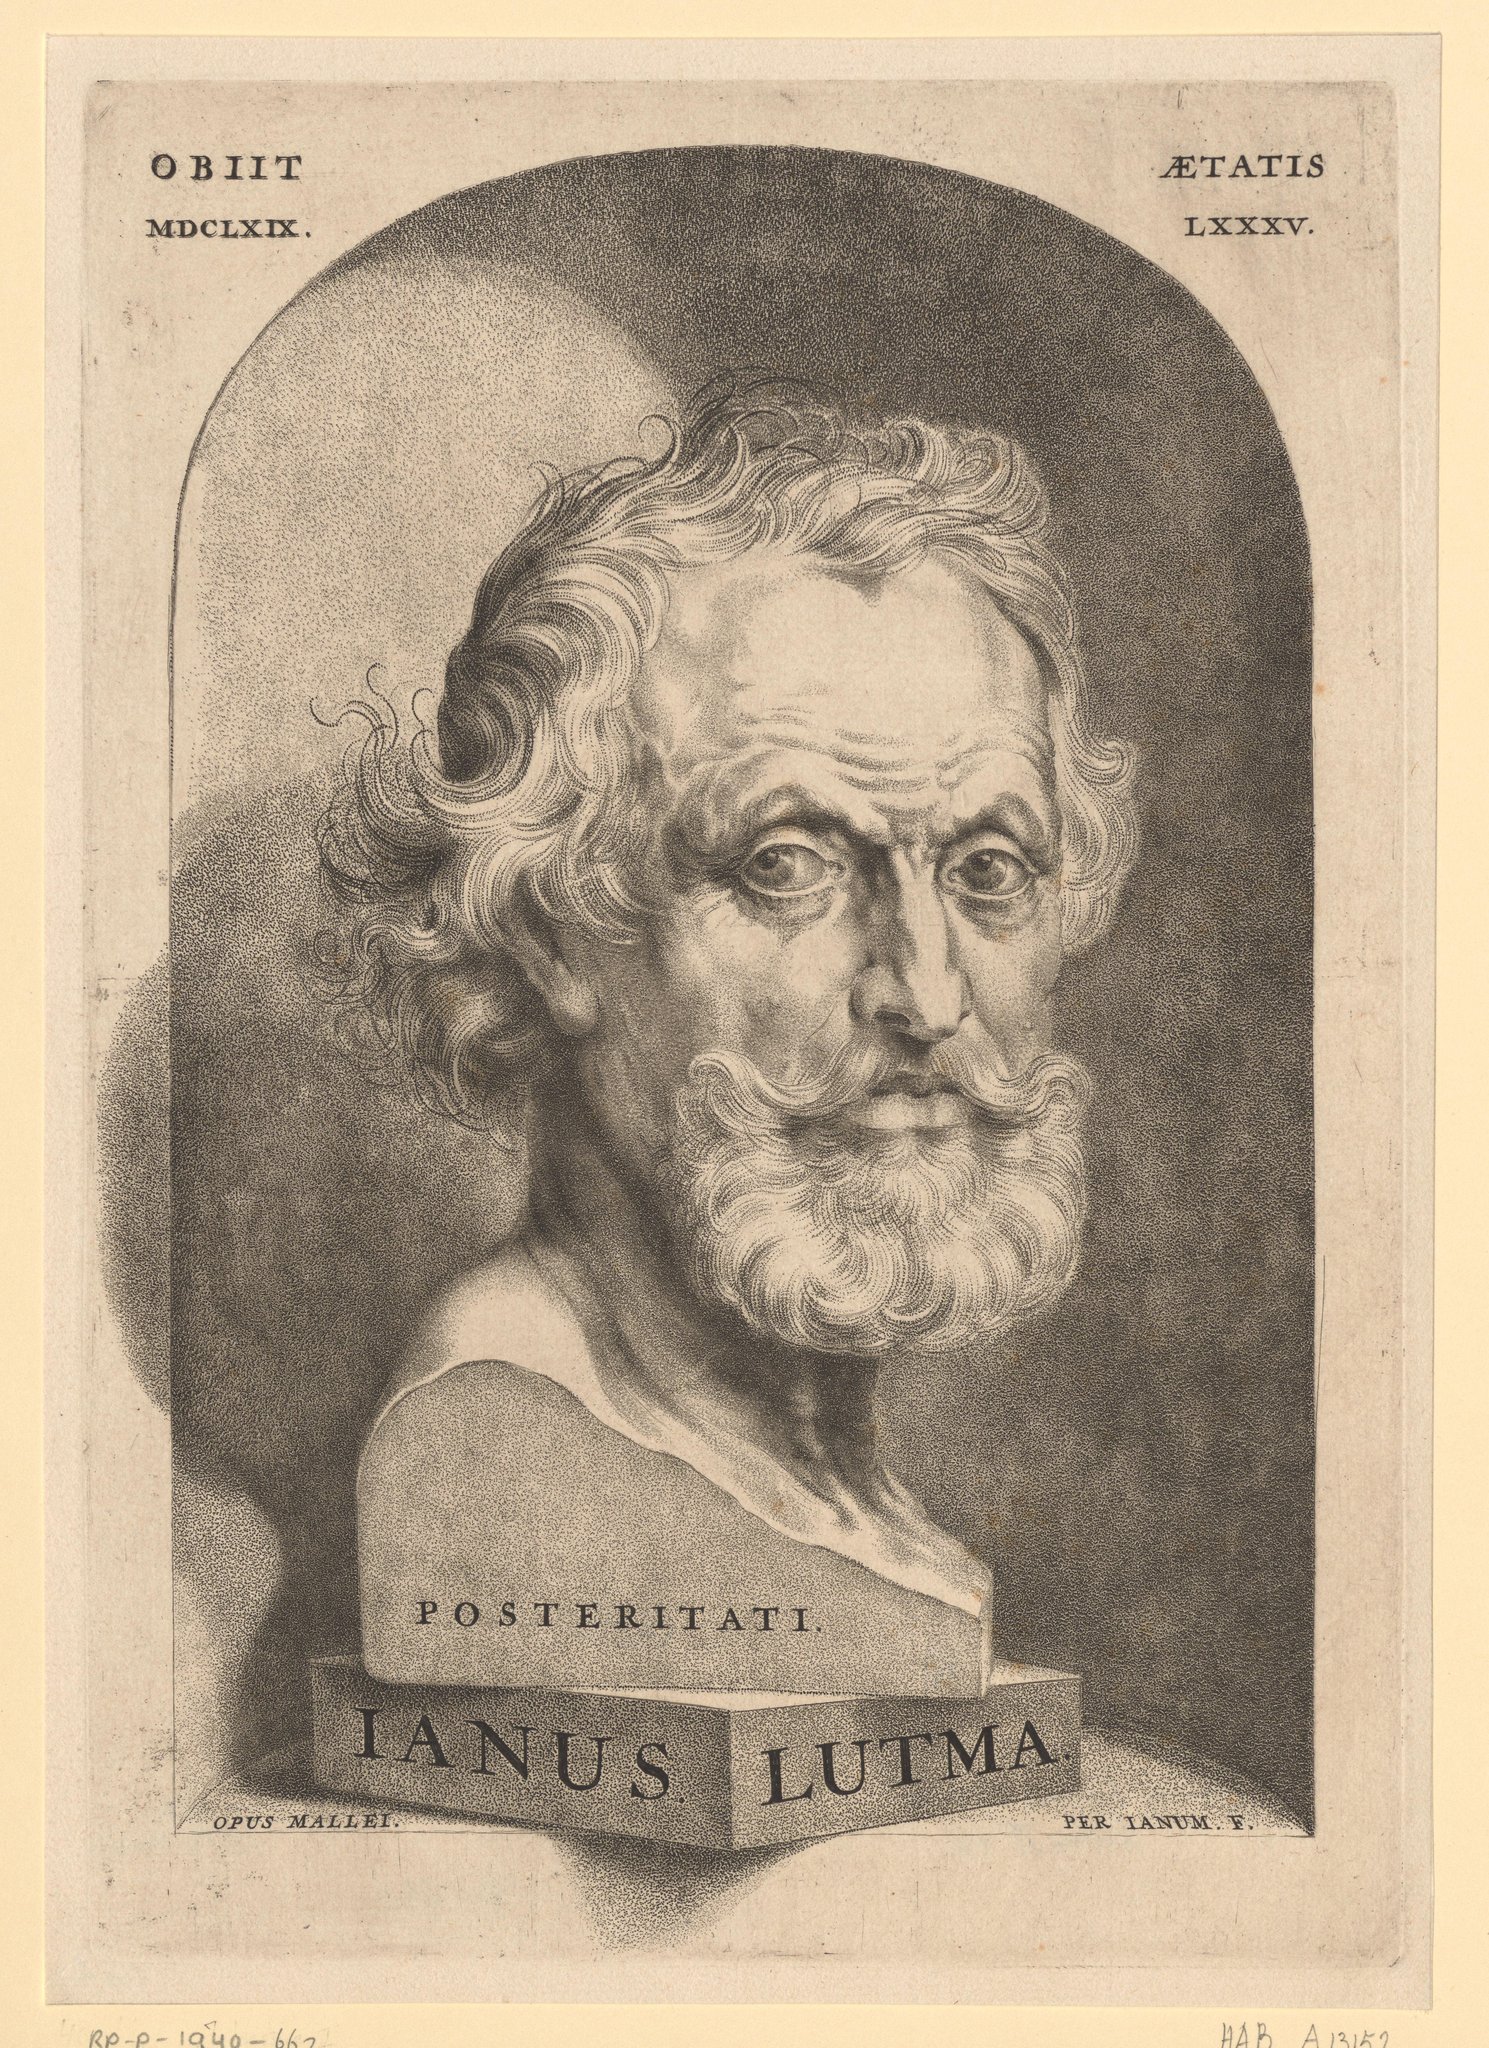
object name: print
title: Portretbuste van Johannes Lutma de Oude op 85-jarige leeftijd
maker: johannes lutma (1624-1689)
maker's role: print maker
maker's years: 1624-1689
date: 1669-1689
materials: paper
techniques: engraving, intaglio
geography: amsterdam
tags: amsterdam, print maker, draughtsman, silversmith, johannes lutma (1584-1669), historical persons, jeweller, goldsmith, silversmith, piece of sculpture, reproduction of a piece of sculpture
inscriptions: collector's mark: Lugt 2760, collector's mark: Lugt 2228